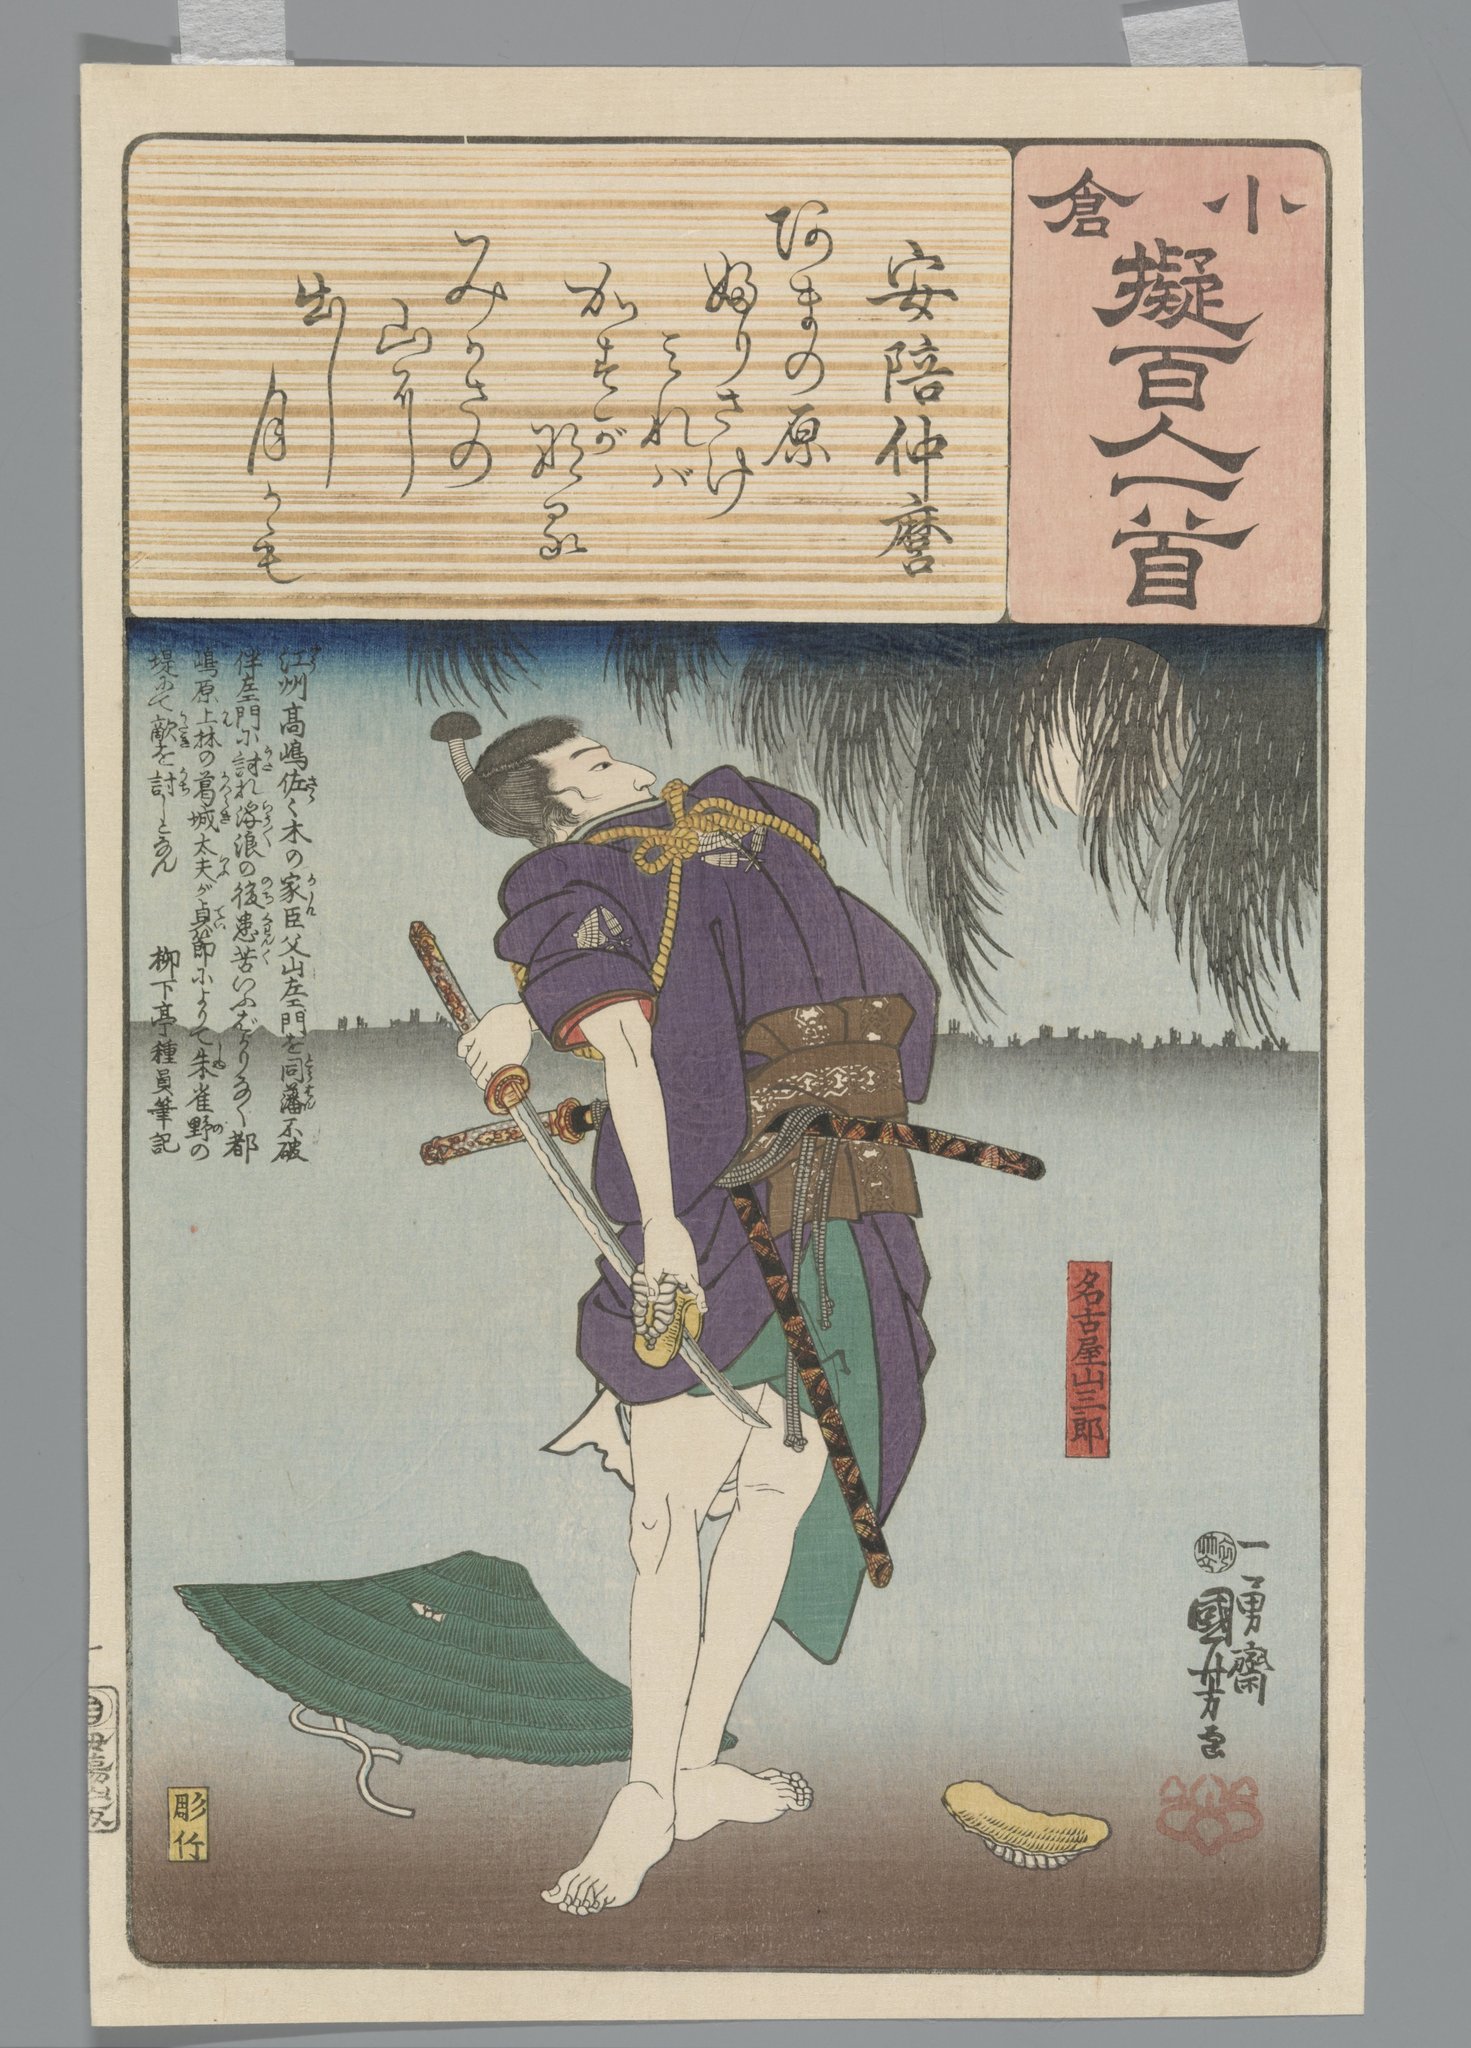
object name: print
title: Ogura Imitation of the One Hundred Poems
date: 1845-1846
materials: paper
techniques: woodcut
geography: japan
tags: cleaning of material, blood, hacking and thrusting weapons: sword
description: Nagoya Sanzaburô veegt het bloed van zijn vijand van zijn zwaard met zijn sandaal. Scene uit een kabukitoneelstuk. Gedicht door Abe no Nakamaro.